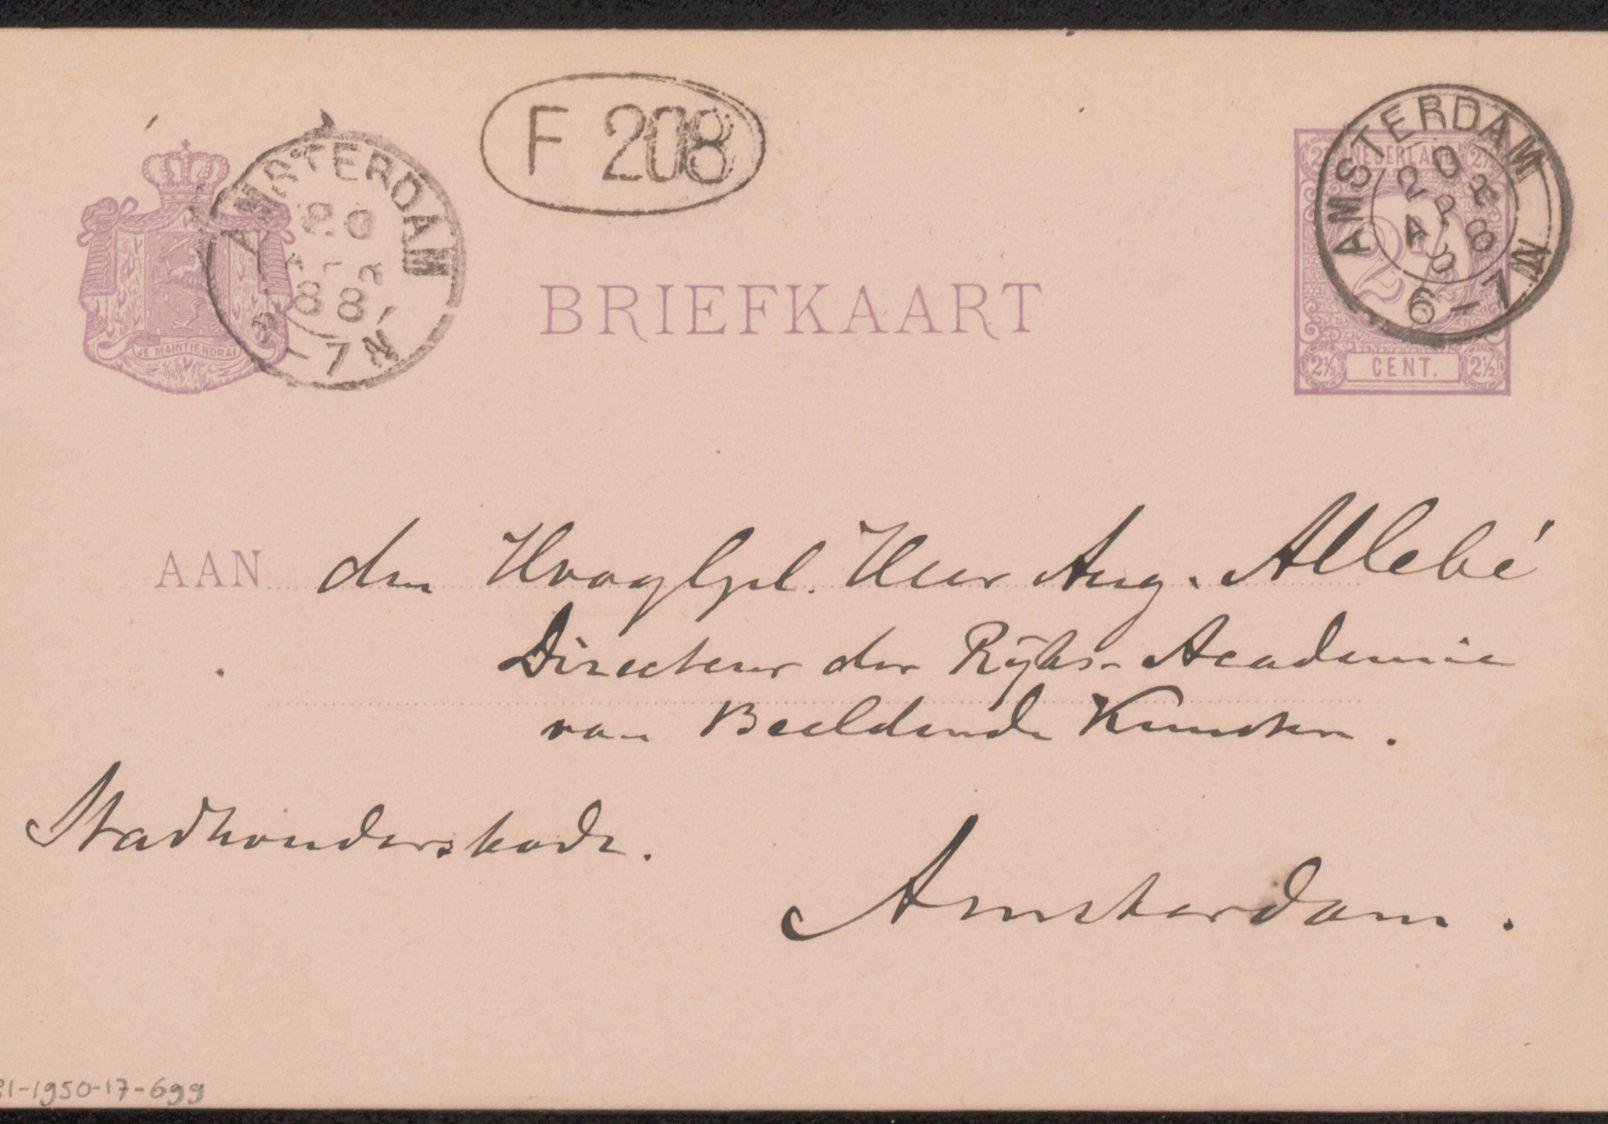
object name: postcard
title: Briefkaart aan August Allebé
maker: jérôme alexander sillem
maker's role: politician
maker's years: 1840-1912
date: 1888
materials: cardboard, ink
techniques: pen, writing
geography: amsterdam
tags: draughtsman, august allebé